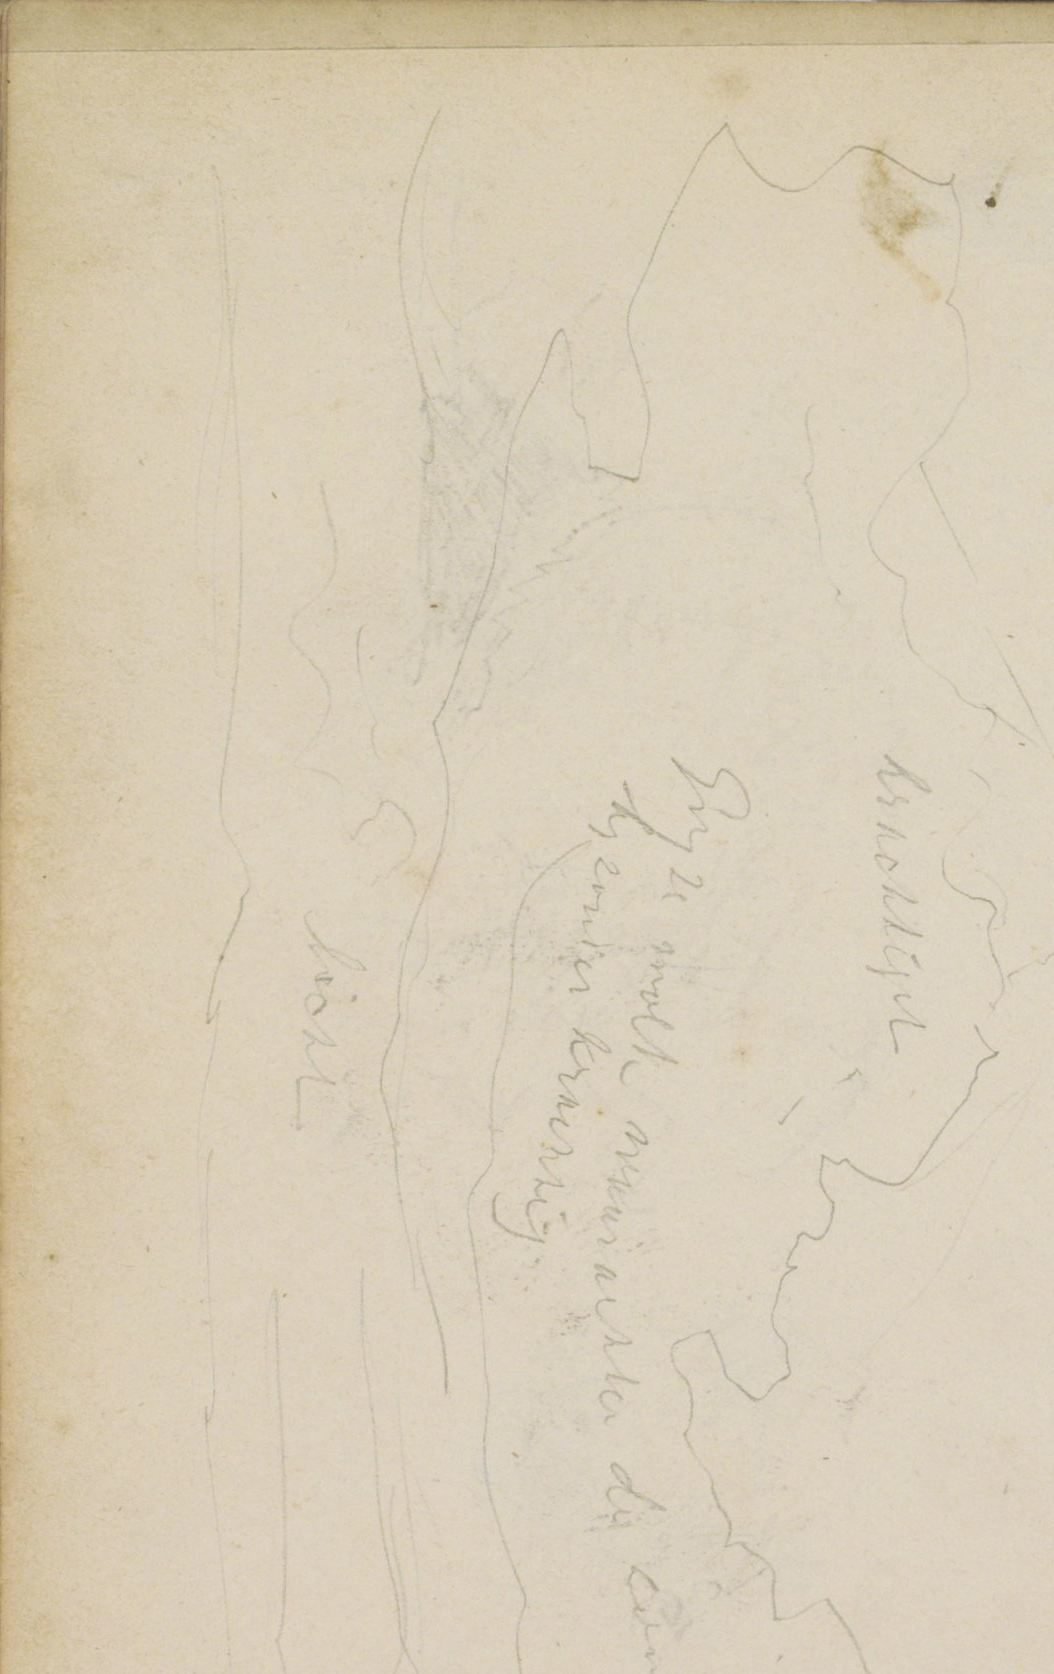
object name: sketchbook leaf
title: Wolken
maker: johannes tavenraat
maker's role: draughtsman, painter, print maker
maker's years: 1809-1881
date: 1839-1872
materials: paper, pencil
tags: clouds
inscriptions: kleurnotitie, handgeschreven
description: Blad 44 verso uit een schetsboek met 73 bladen.